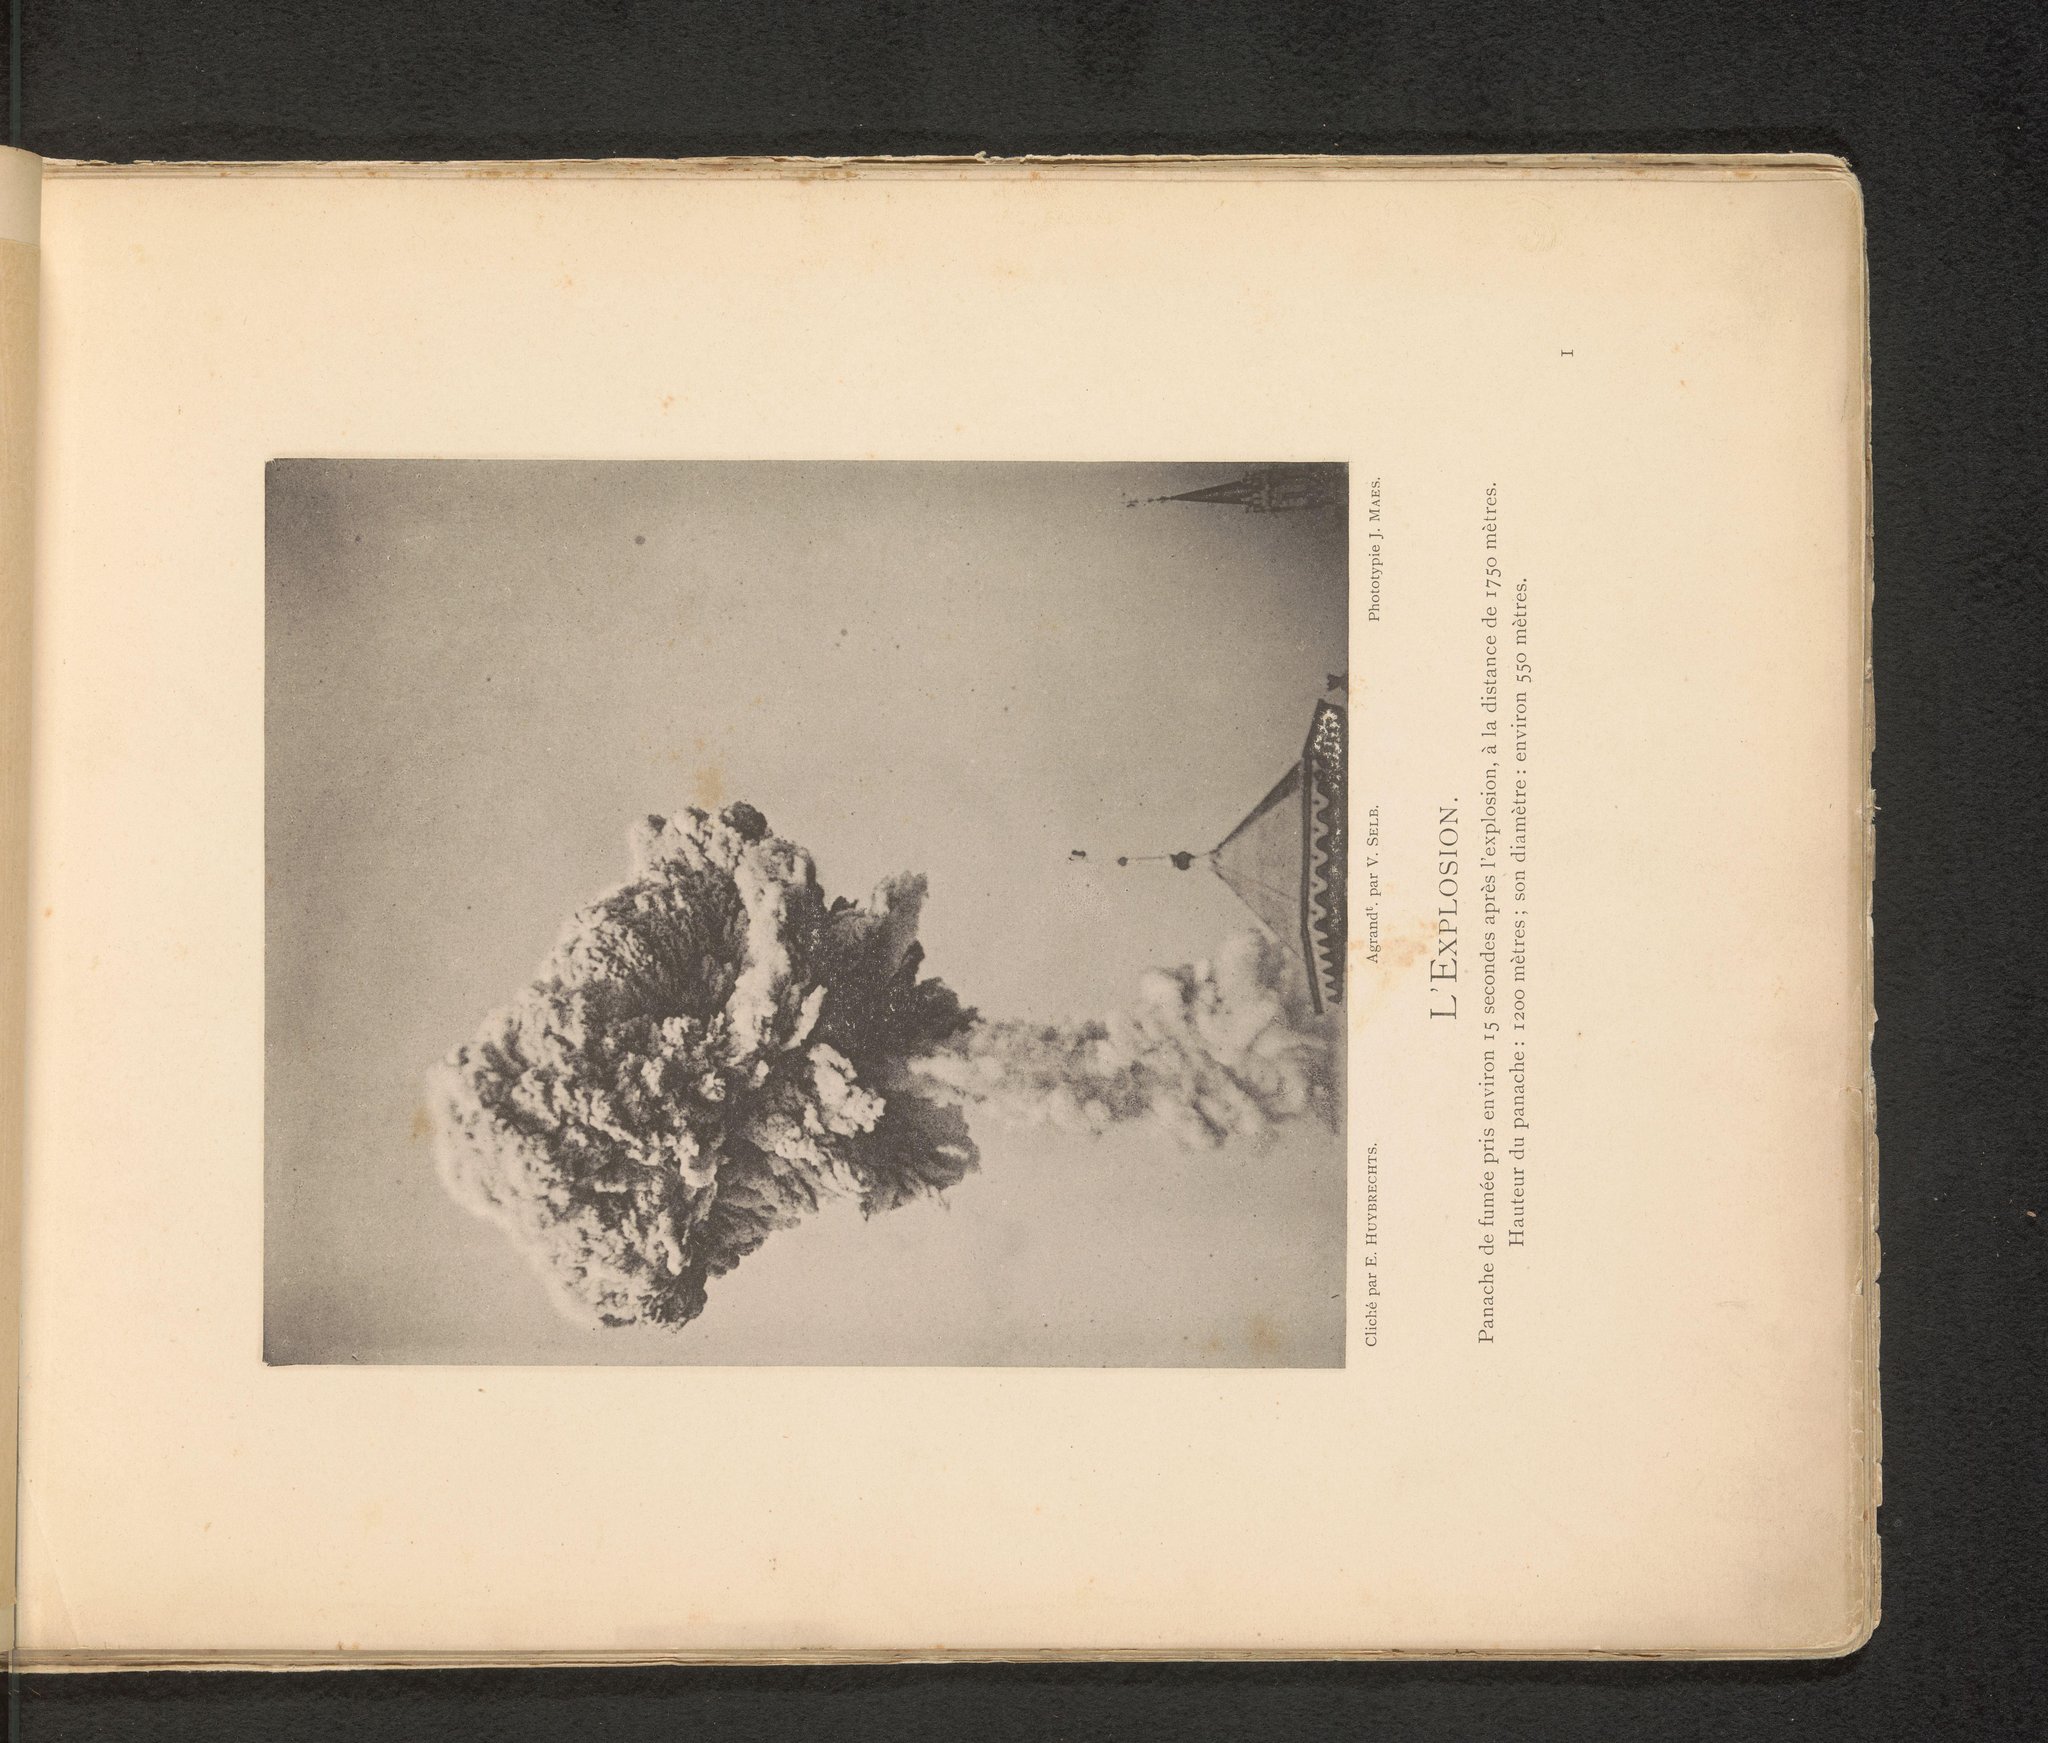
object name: photomechanical print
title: L'Explosion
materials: paper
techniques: photograph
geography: oosterweel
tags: gunpowder disaster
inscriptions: inscription: ‘Panache de fumée pris environ 15 secondes après l'explosion, à la distance de 1500 mètres./ Hauteur du panache: 1200 mètres; son diamètre: environ 550 mètres.’, inscription: ‘Agrandt par V. Selb.’, number: ‘1’